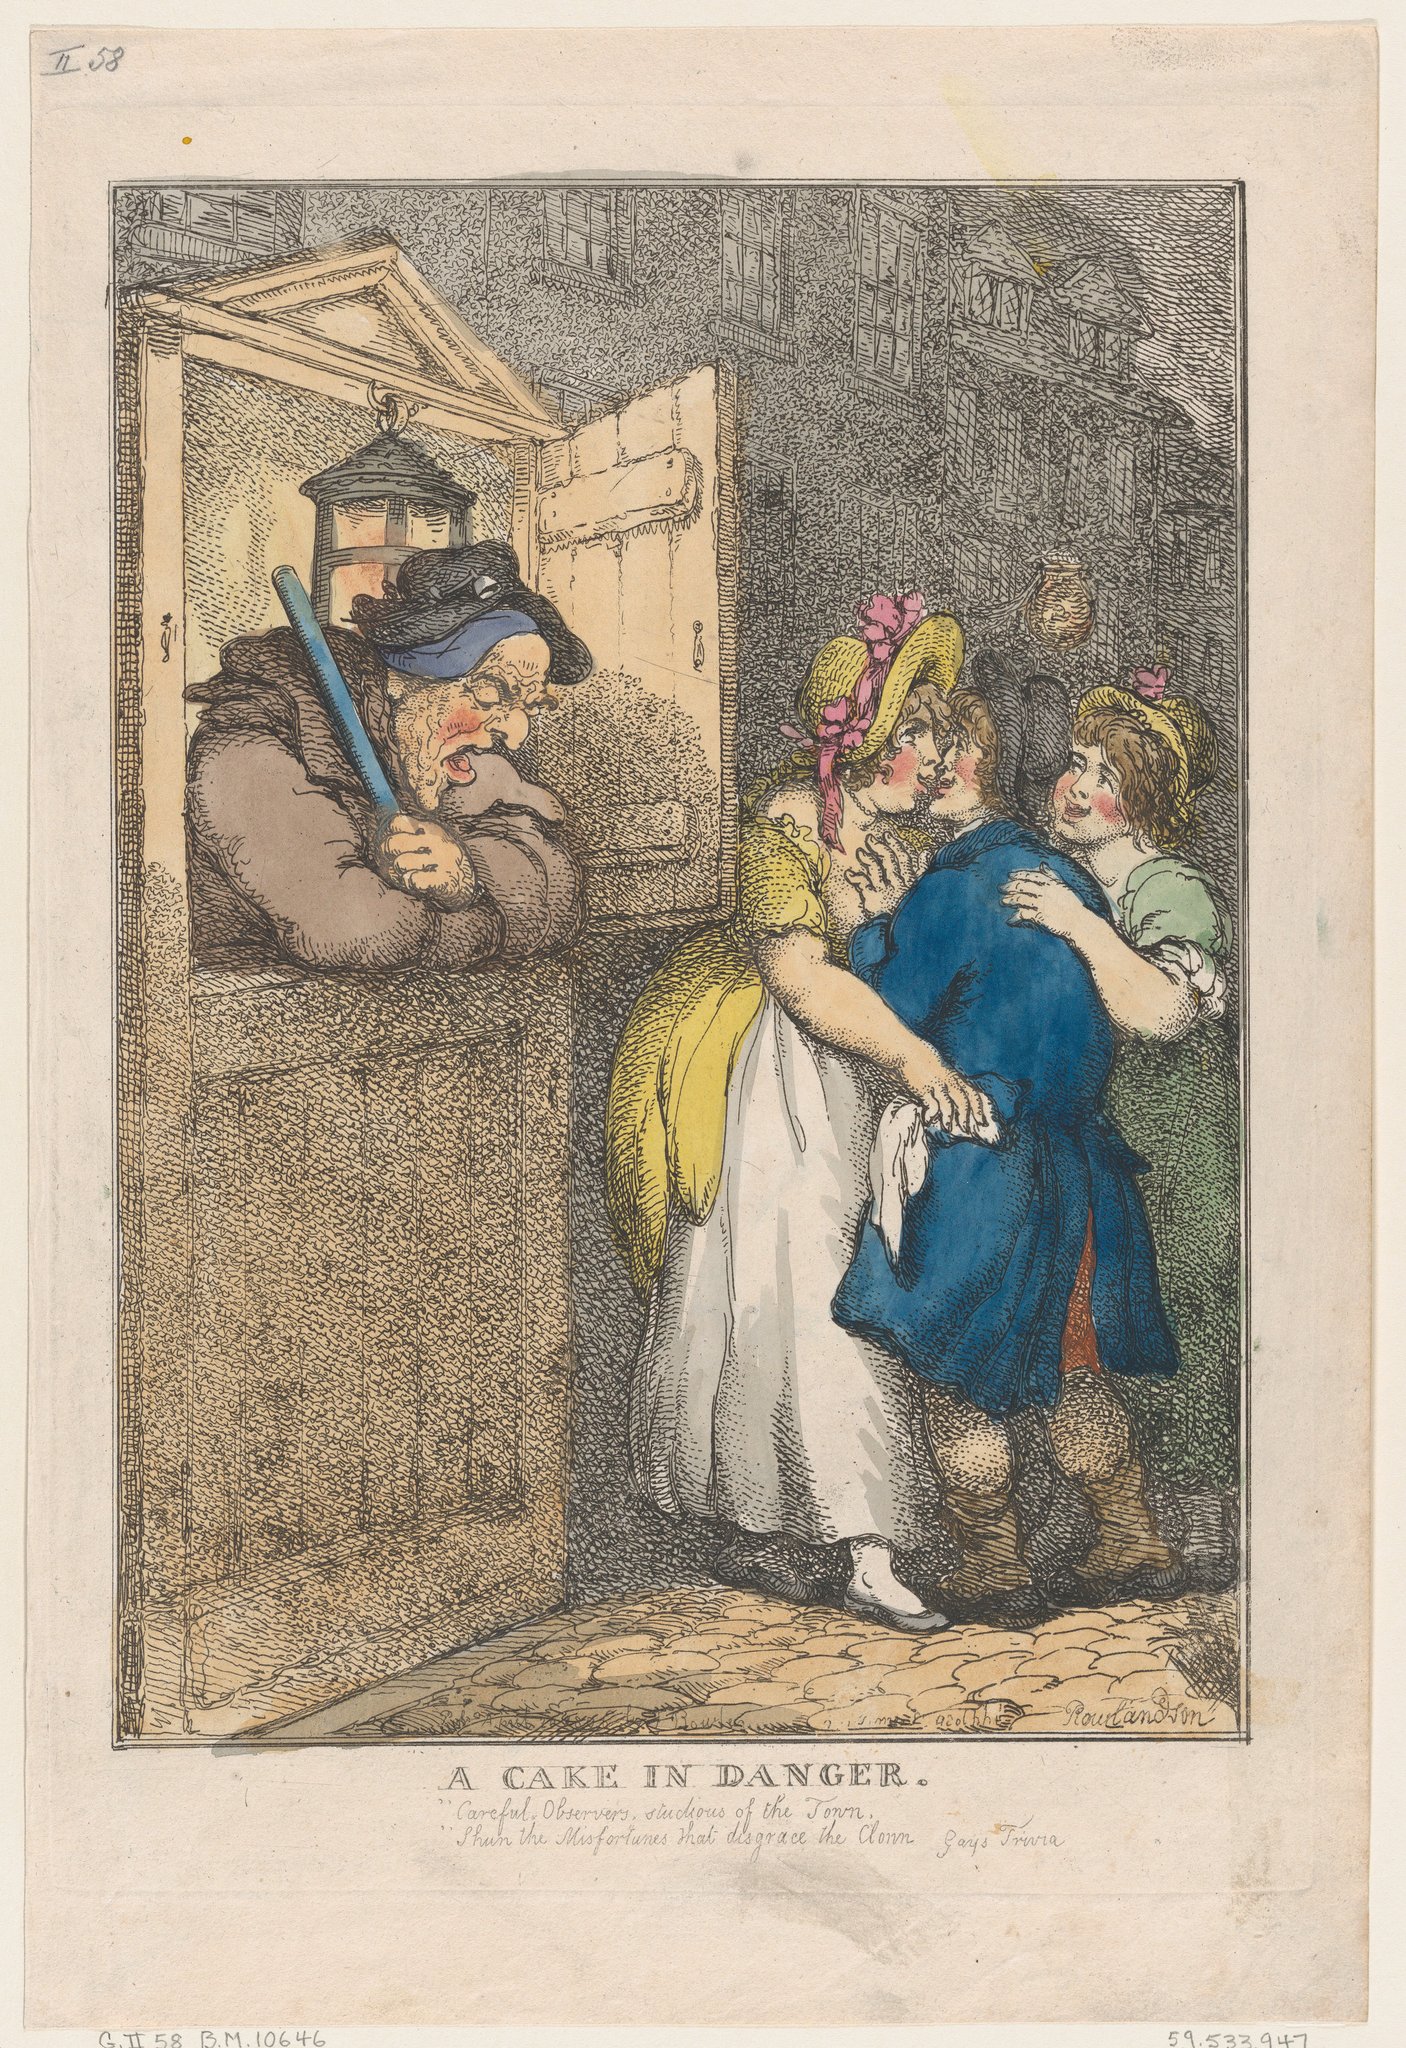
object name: print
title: A Cake in Danger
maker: thomas rowlandson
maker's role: artist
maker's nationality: british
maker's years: 1757-1827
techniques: etching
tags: satire,men,women